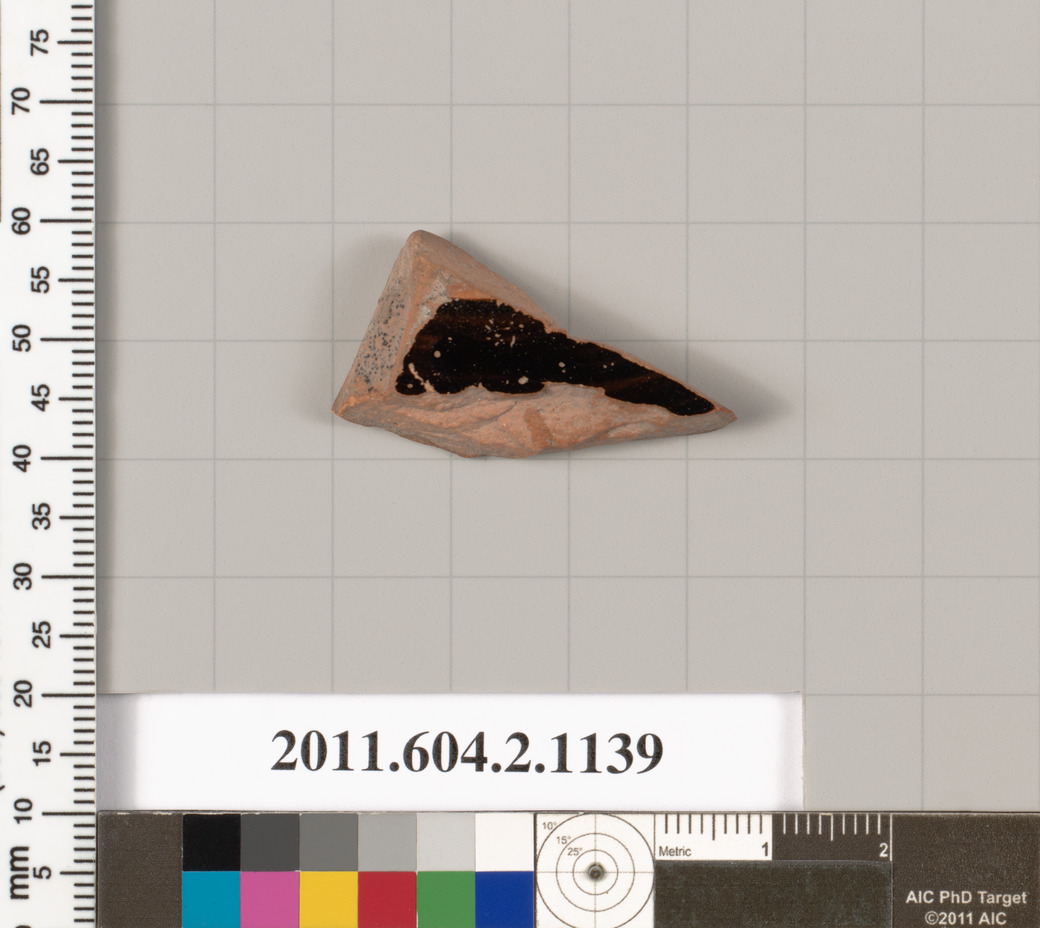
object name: lekanis fragment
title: Terracotta fragment of a lekanis lid (covered dish)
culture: greek, attic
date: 375-351 BCE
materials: terracotta